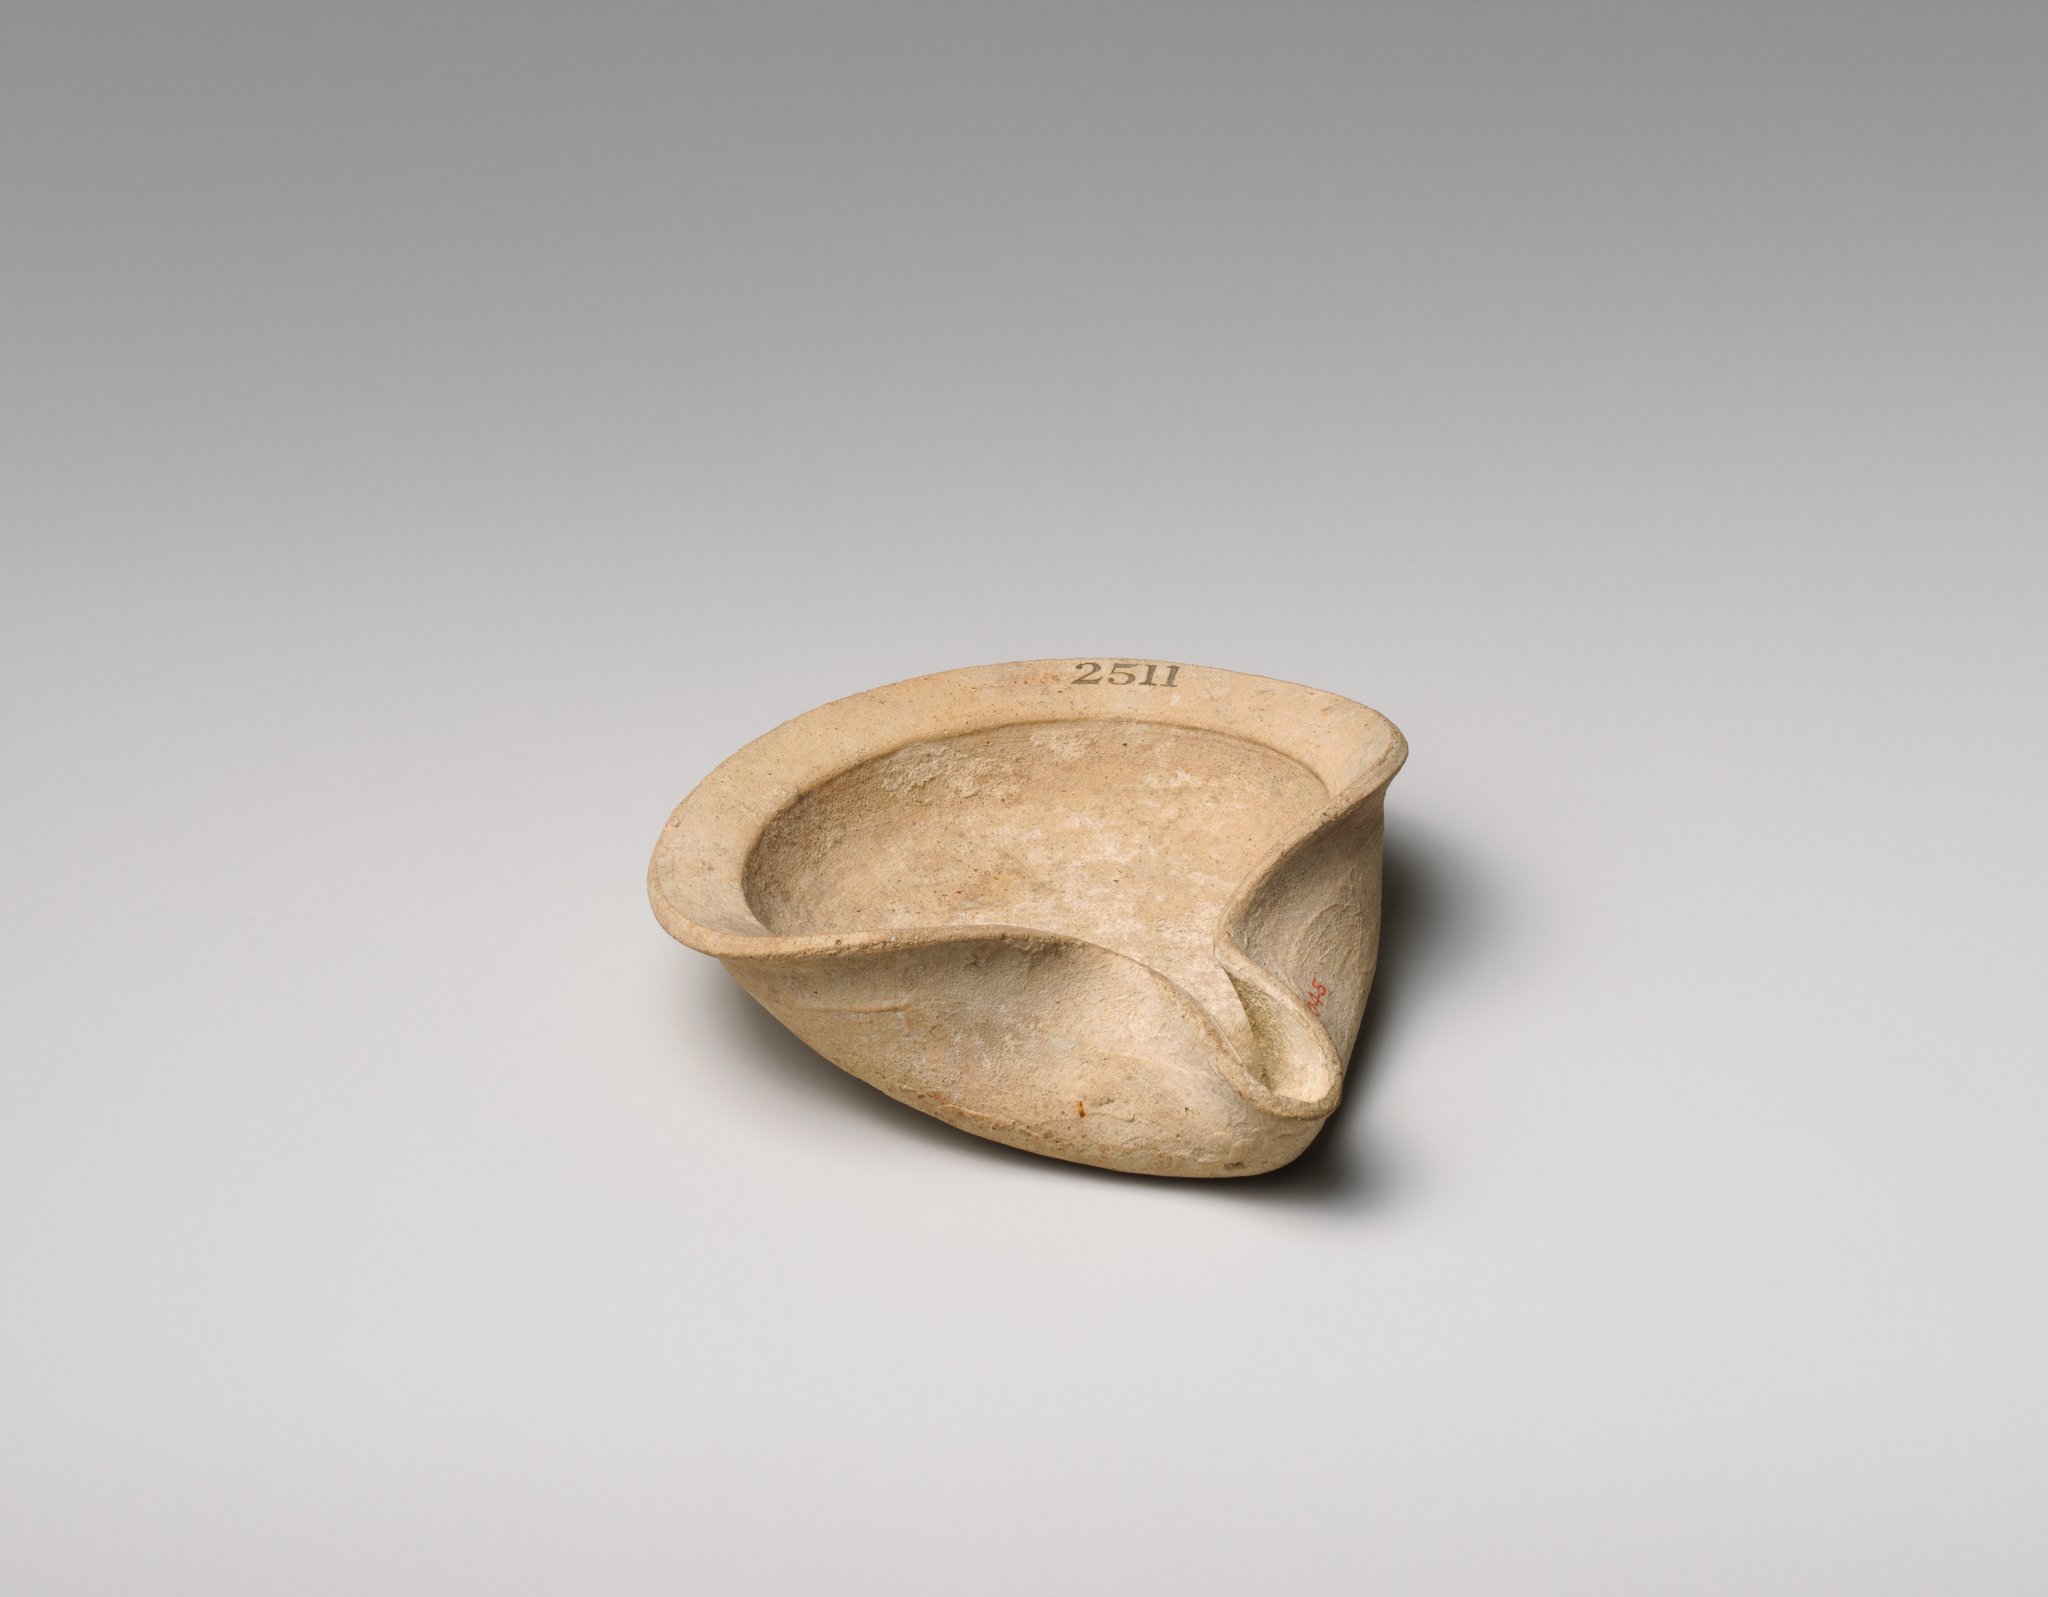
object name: lamp, saucer shaped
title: Terracotta saucer-shaped lamp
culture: cypriot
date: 400-301 BCE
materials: terracotta